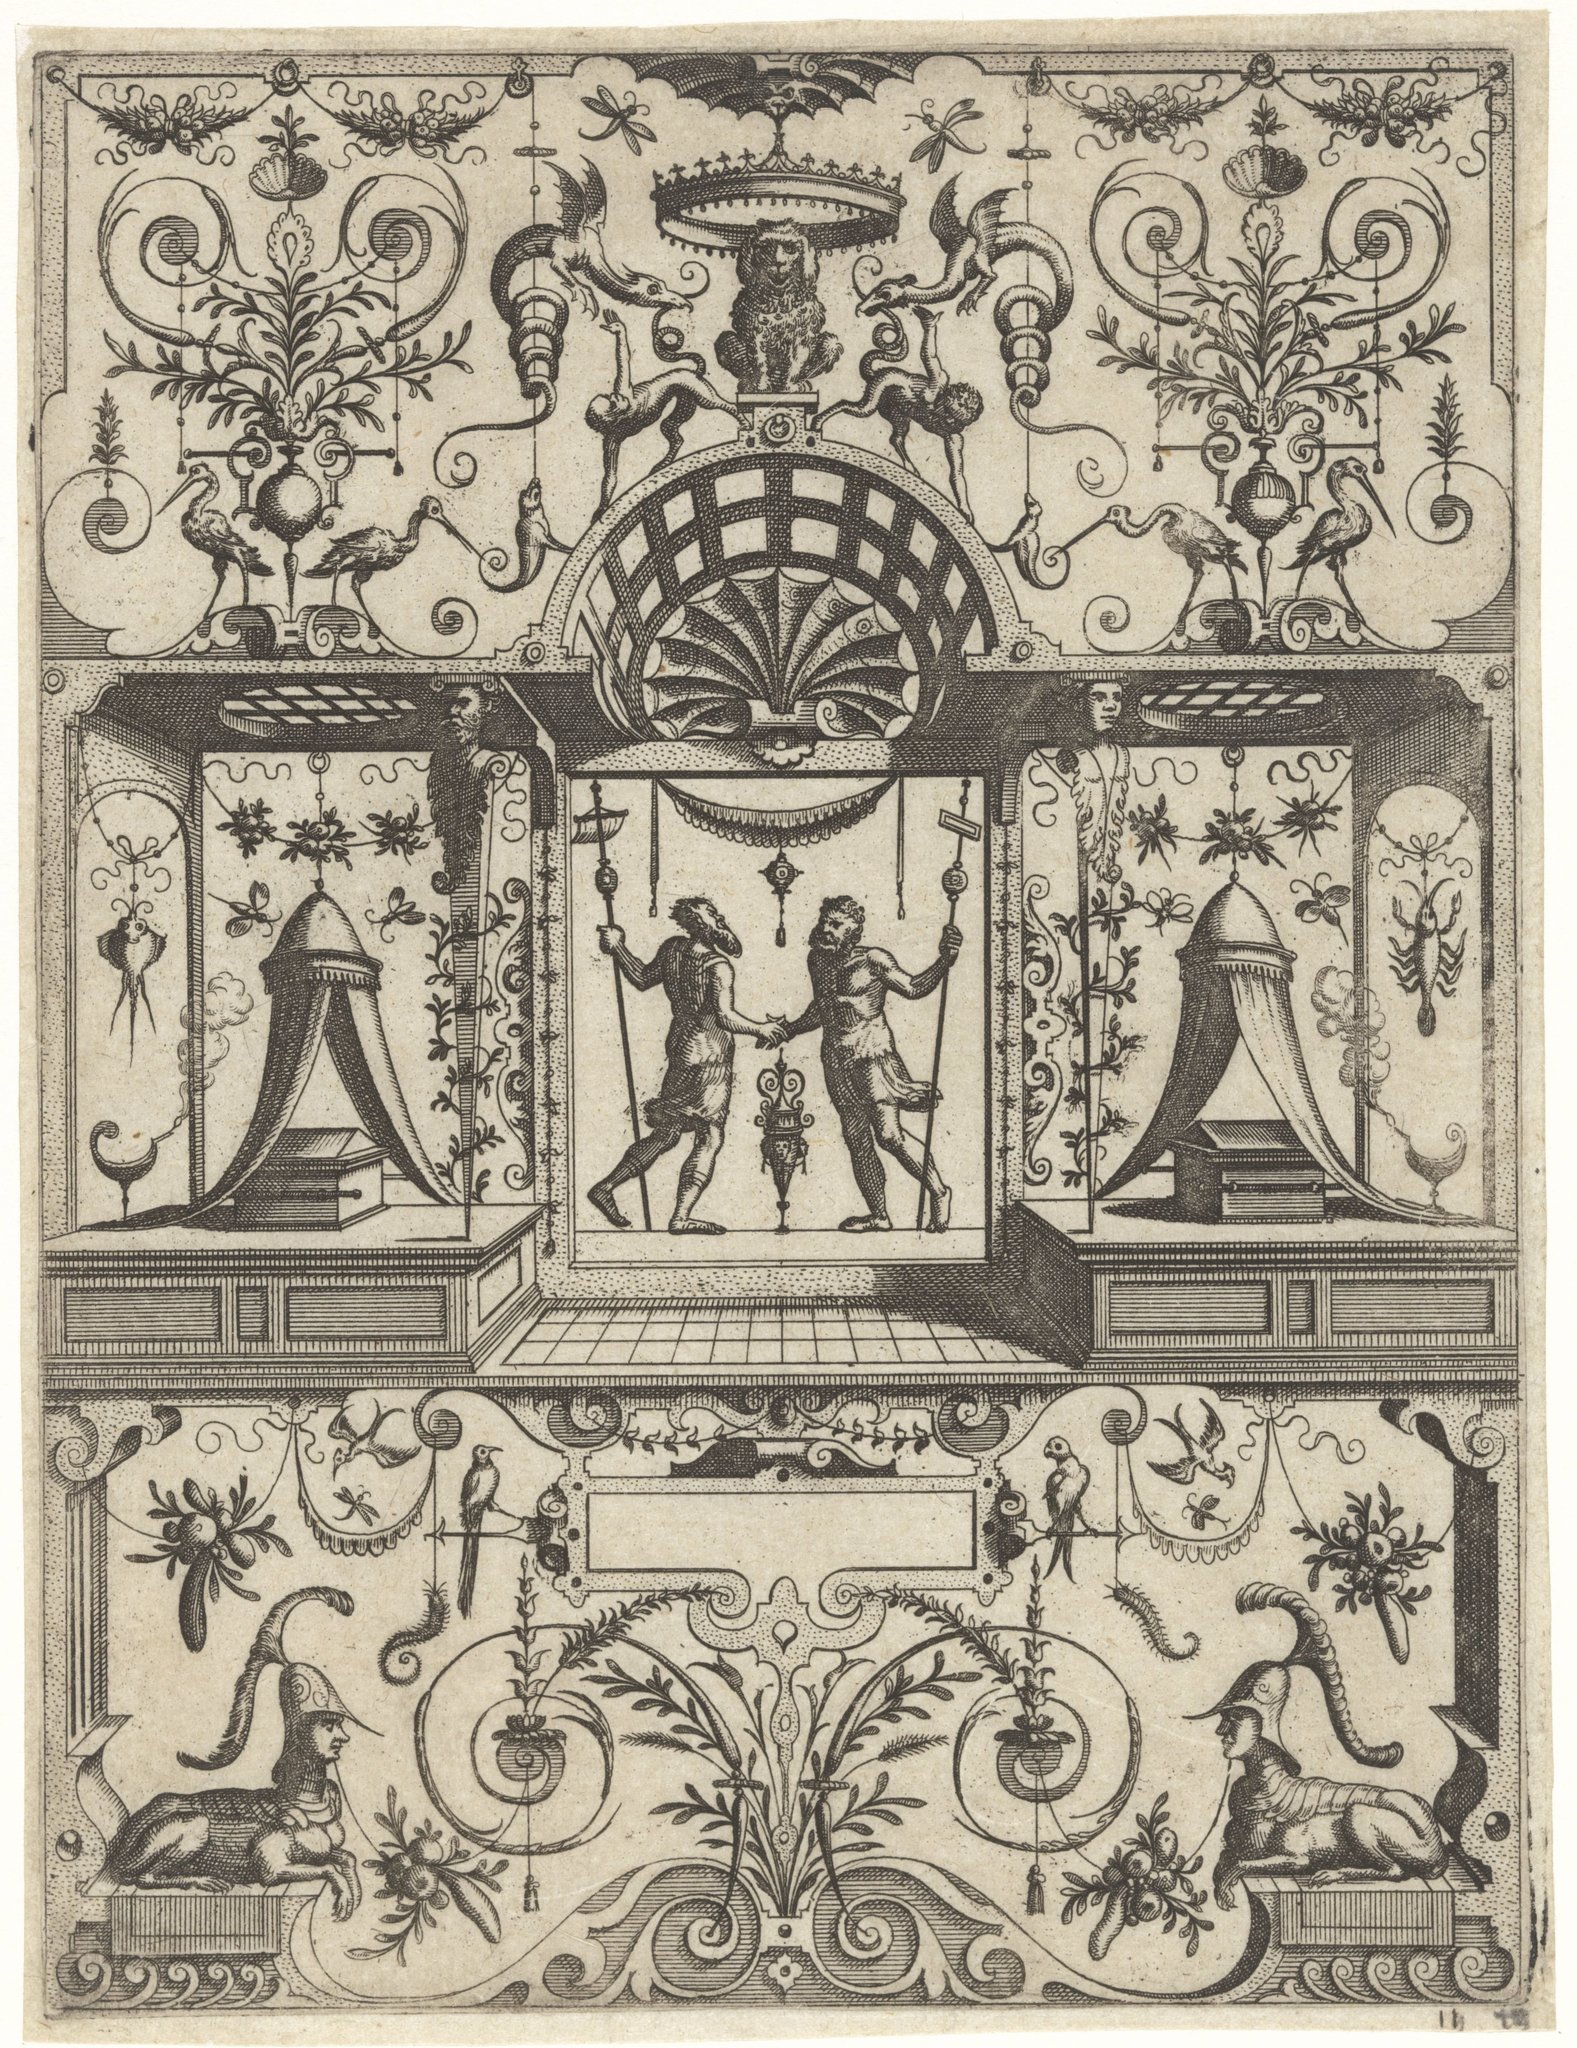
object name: print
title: Grottesco: in diversche manieren…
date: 1565-1571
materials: paper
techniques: etching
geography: netherlands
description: Links en rechts van hen staat hun tent op een verhoging. Linksonder en rechtsonder ligt een gehelmde sfinx. Uit serie van titelblad + 16 bladen met cartouches of architectuurfantasieën met een voorstelling in een omlijsting van grotesken met fabelwezens, dieren, guirlandes, trofeeën en mascarons.